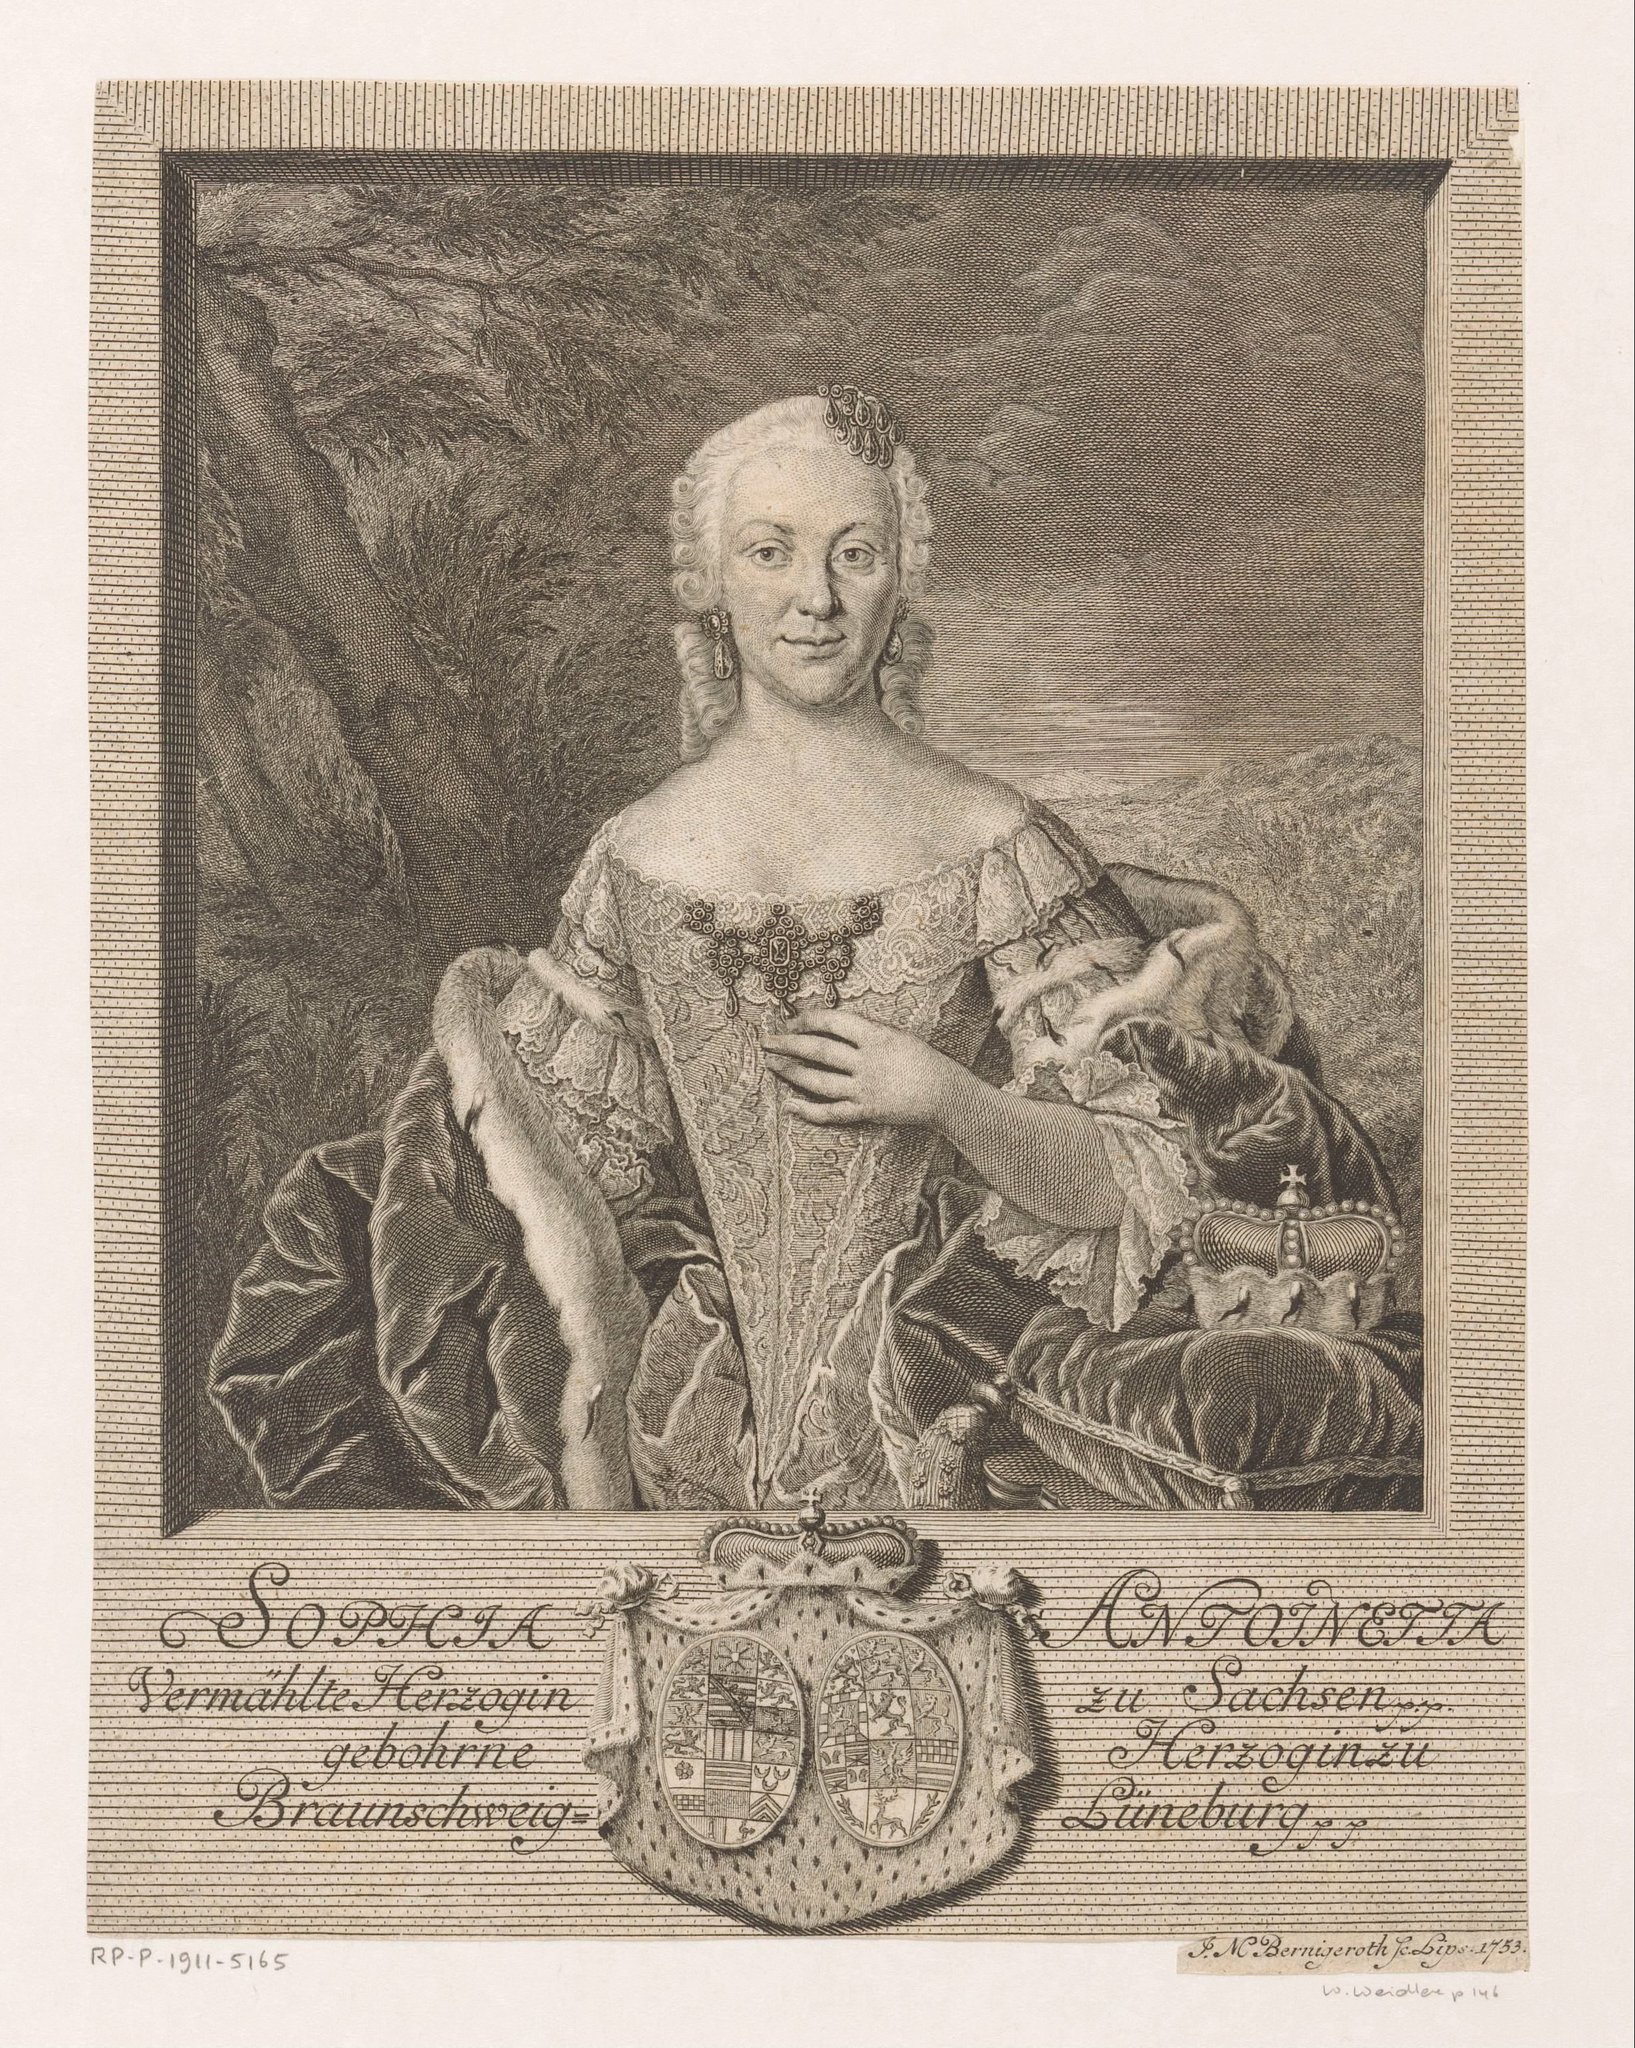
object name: print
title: Portret van Sophia Antonia von Sachsen-Coburg-Saalfeld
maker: johann martin bernigeroth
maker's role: print maker, publisher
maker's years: 1713-1767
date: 1753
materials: paper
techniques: engraving, etching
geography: leipzig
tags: crown (symbol of sovereignty), historical persons - bb - woman, ornaments, jewels, mantle, gown, dress (symbol of sovereignty), armorial bearing, heraldry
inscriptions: collector's mark: Lugt 2228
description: Prent ook gebruikt in: Rimius, Heinrich. Geschichte des Hauses Braunschweig. Coburg: Georg Otto, 1753.